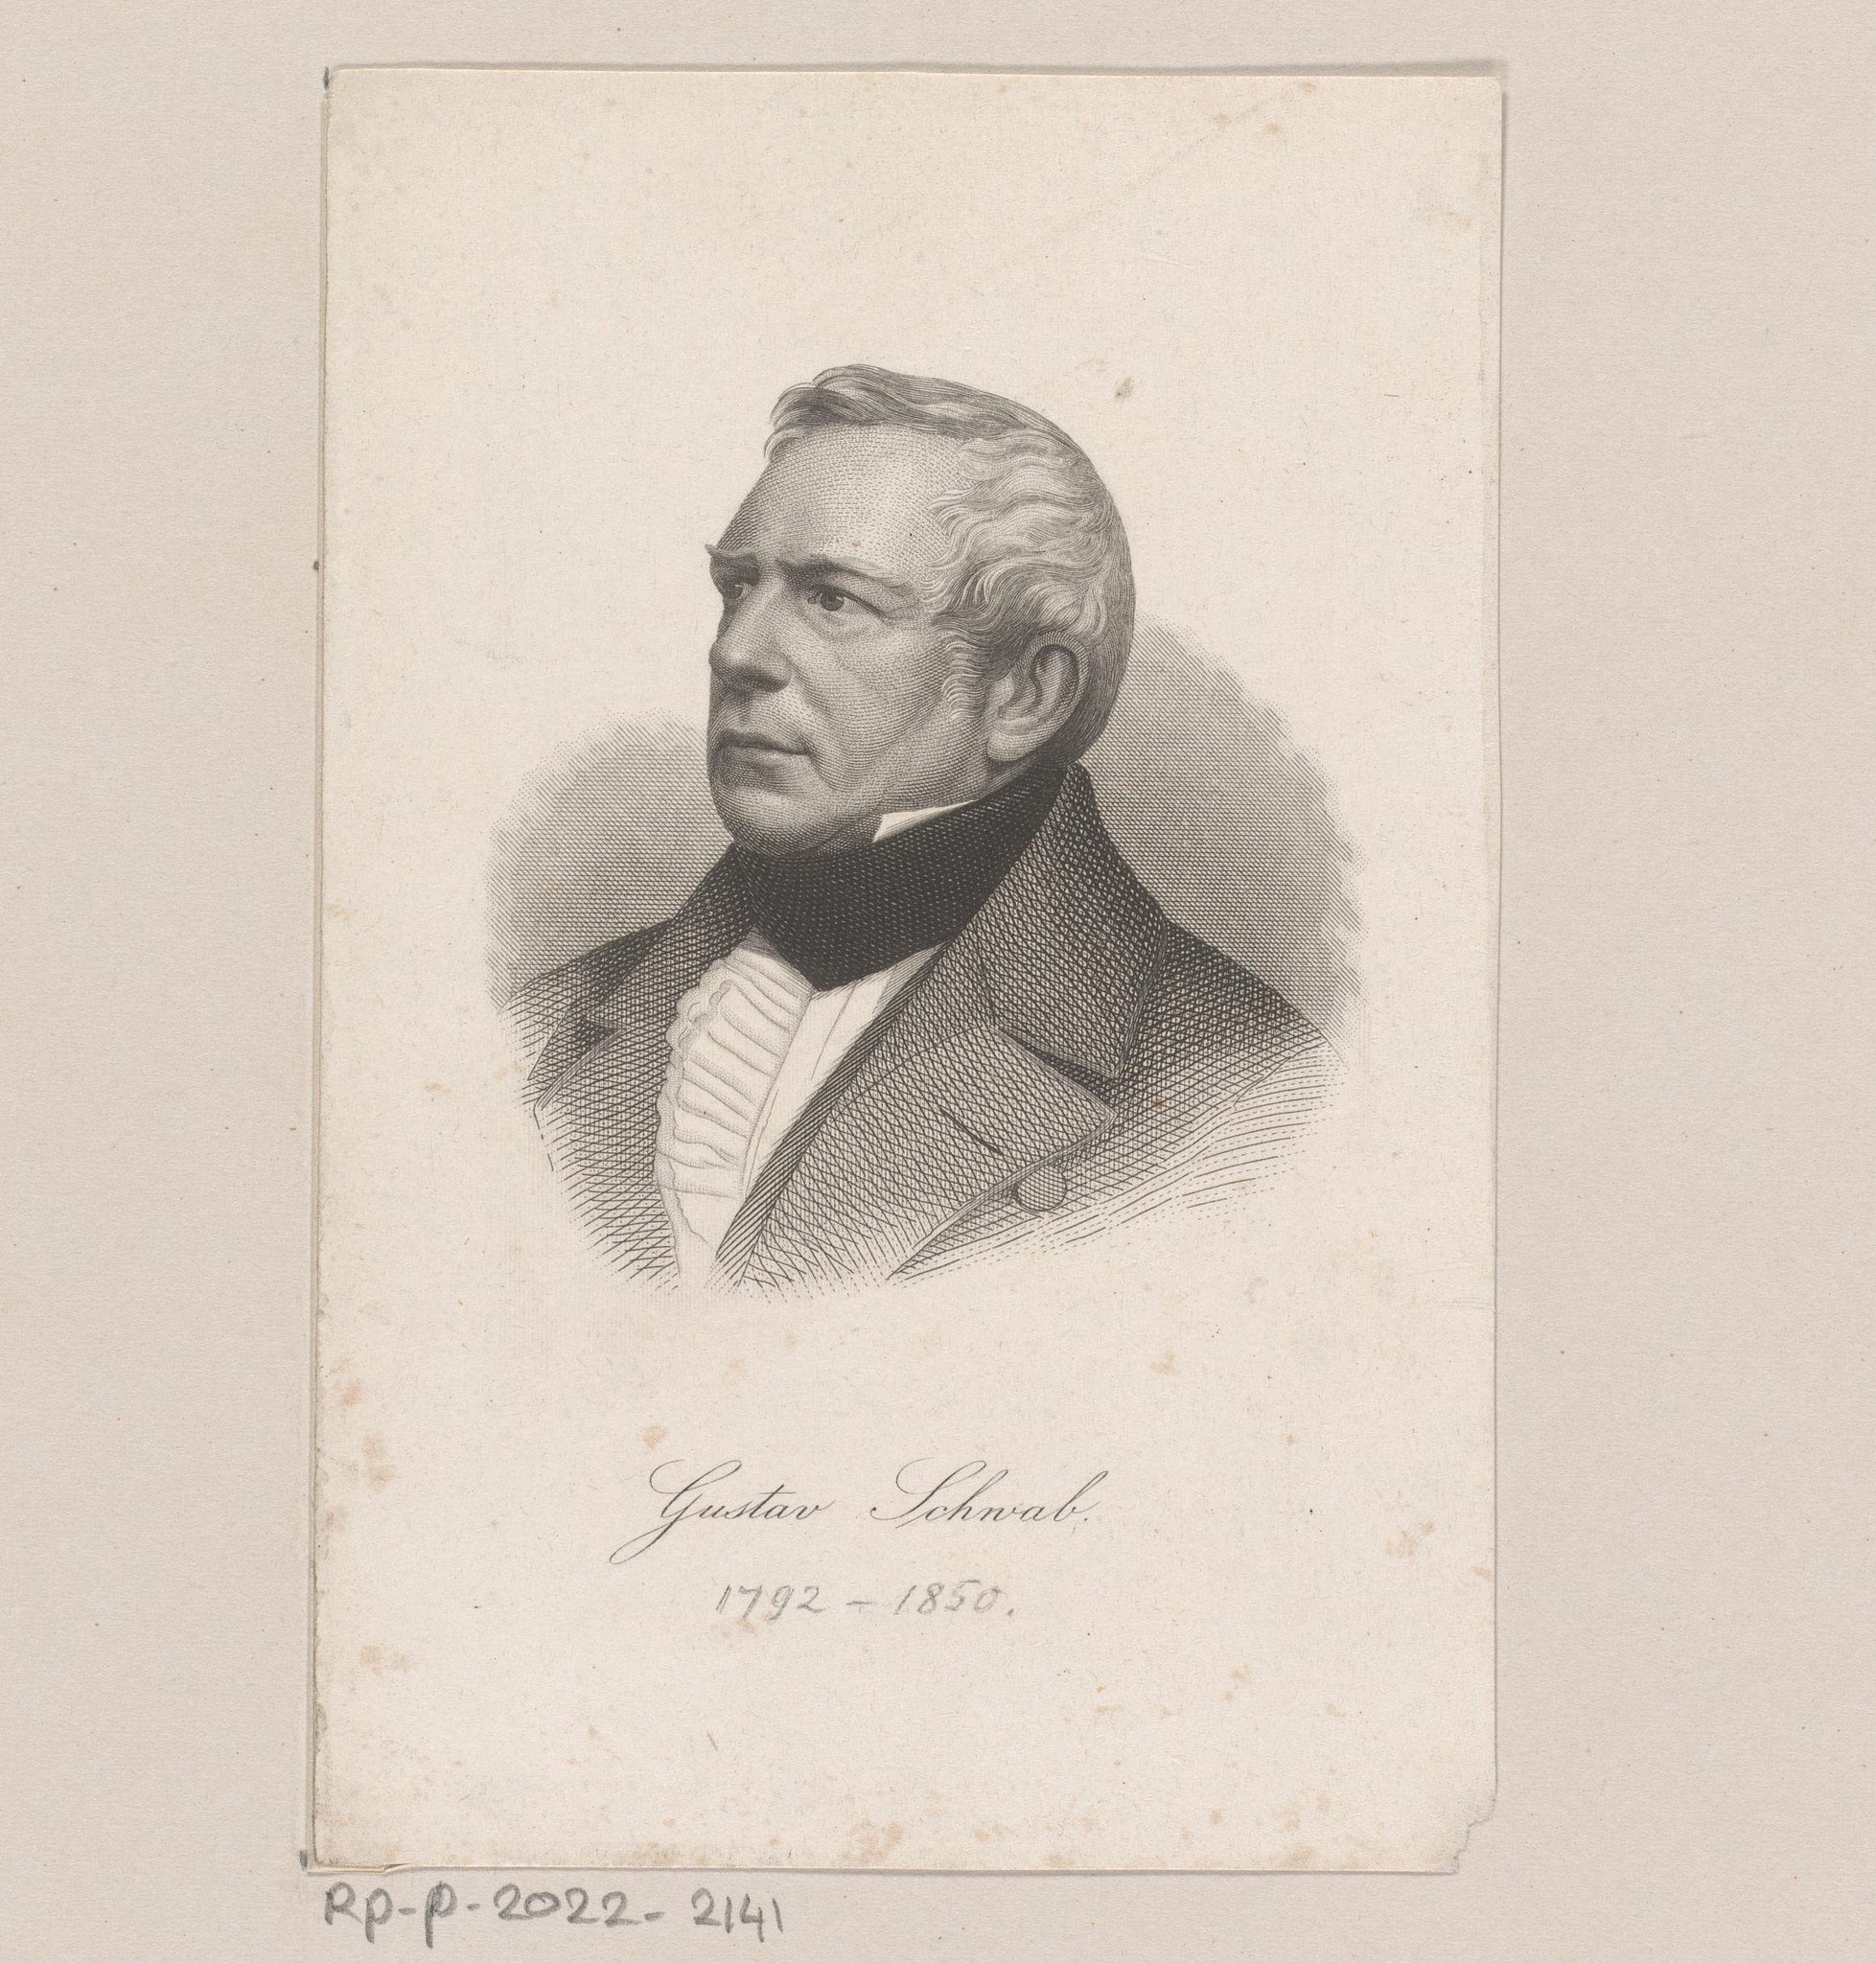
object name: print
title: Portret van Gustav Schwab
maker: Anonymous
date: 1742-1799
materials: paper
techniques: engraving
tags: historical persons, portrait of a writer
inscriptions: inscription: ‘1792 - 1850’